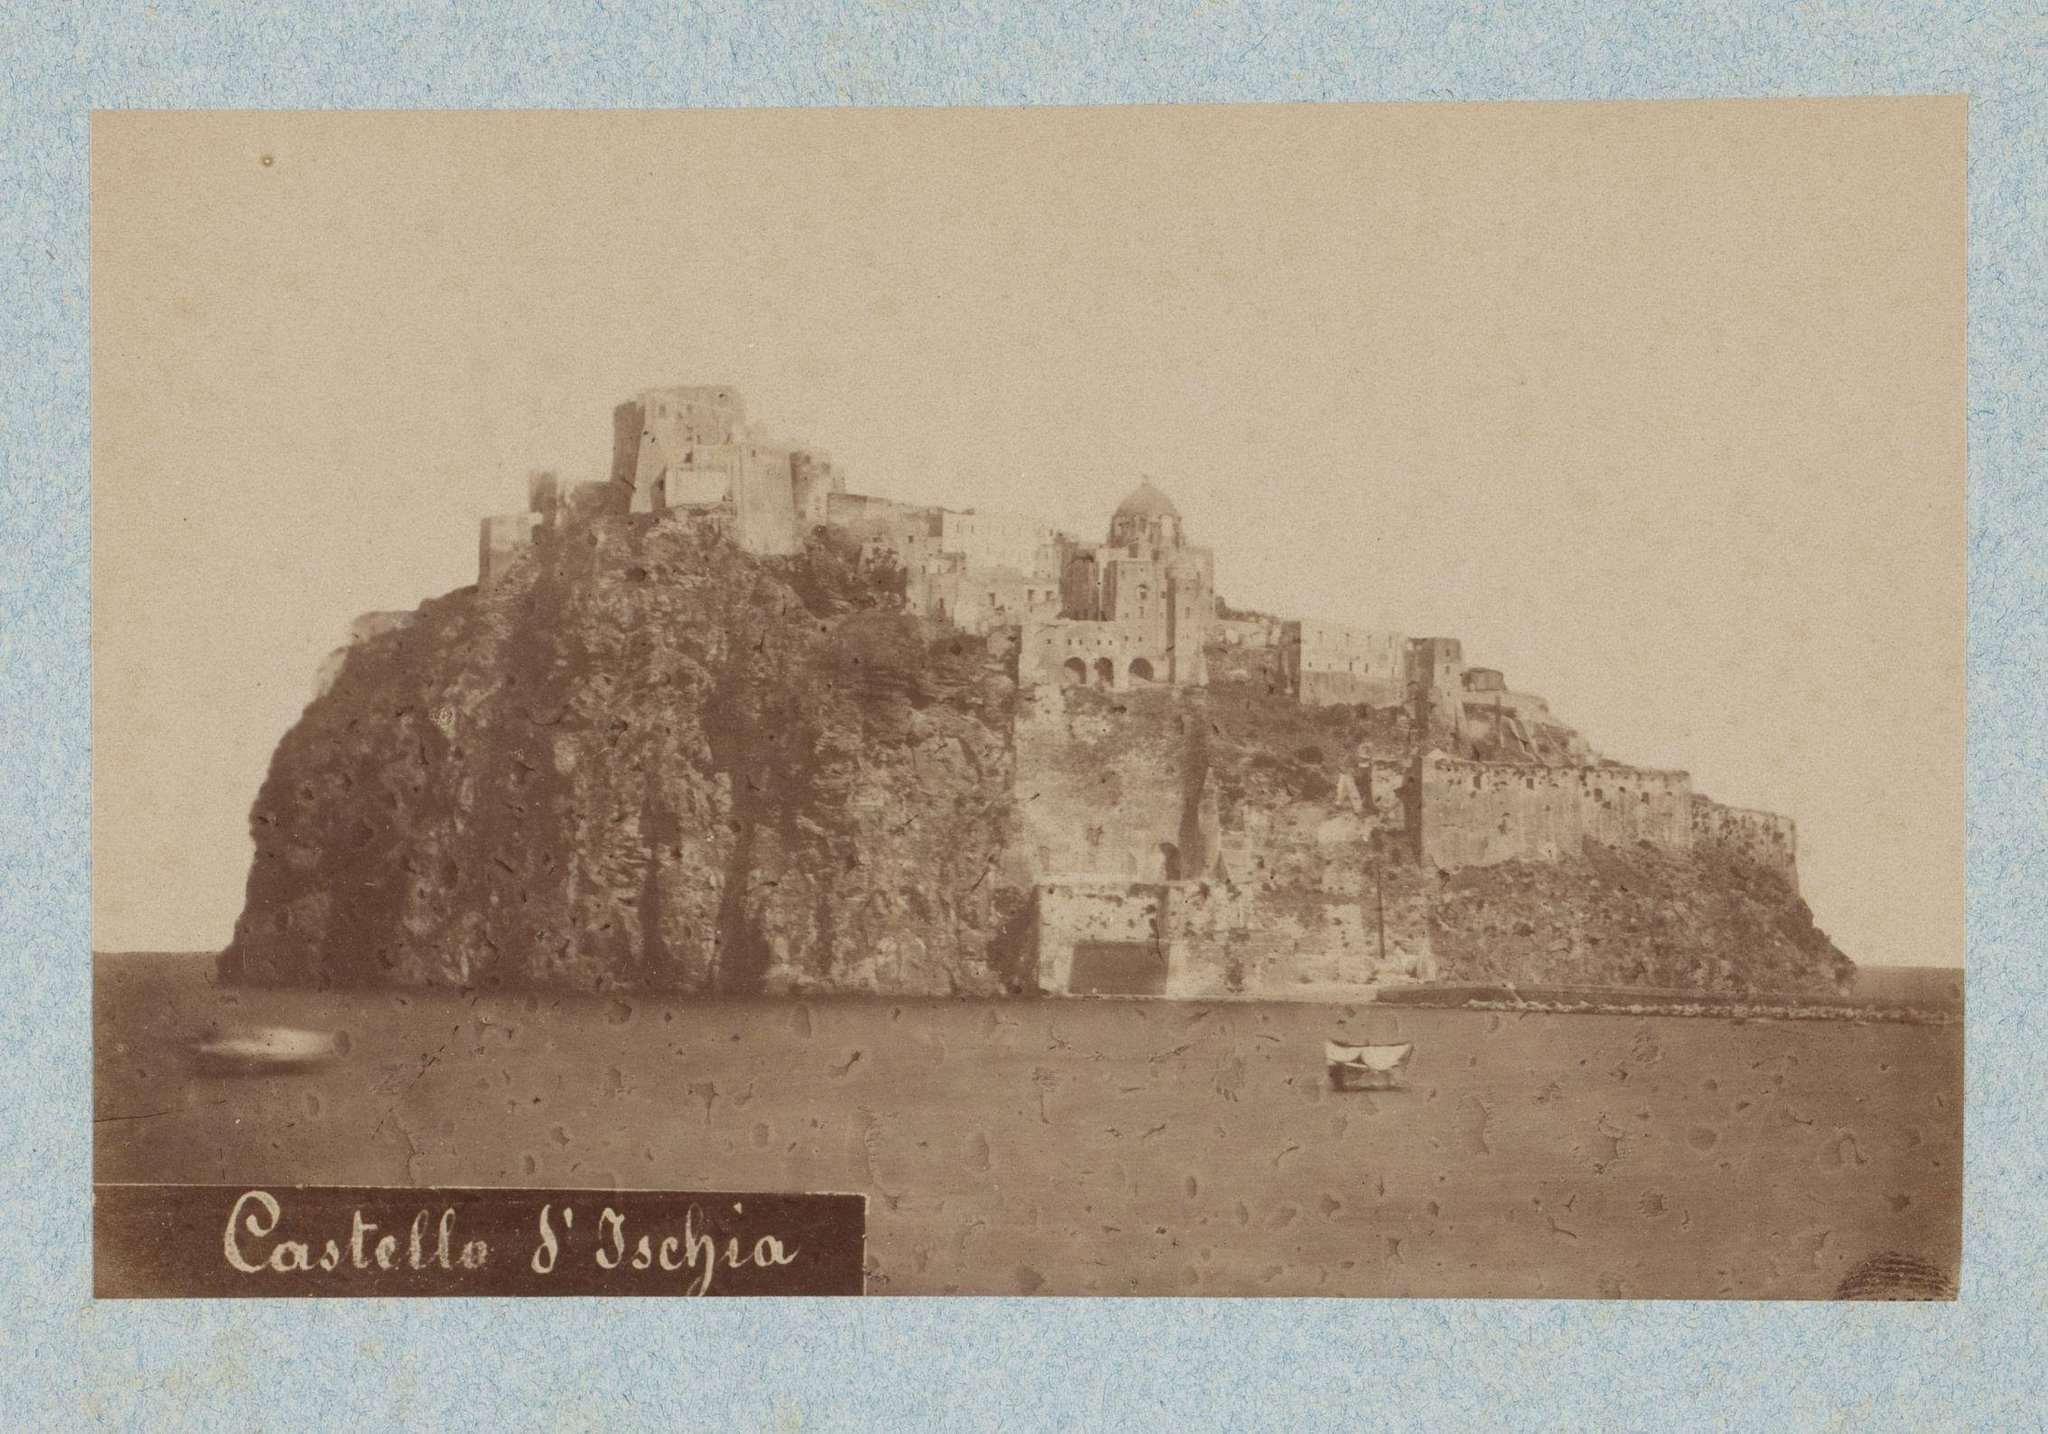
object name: photograph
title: Castello d'Ischia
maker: Anonymous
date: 1872-1900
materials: cardboard, paper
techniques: albumen print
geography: ischia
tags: island, landscape with tower or castle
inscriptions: collector's mark: ‘VOSMAER’